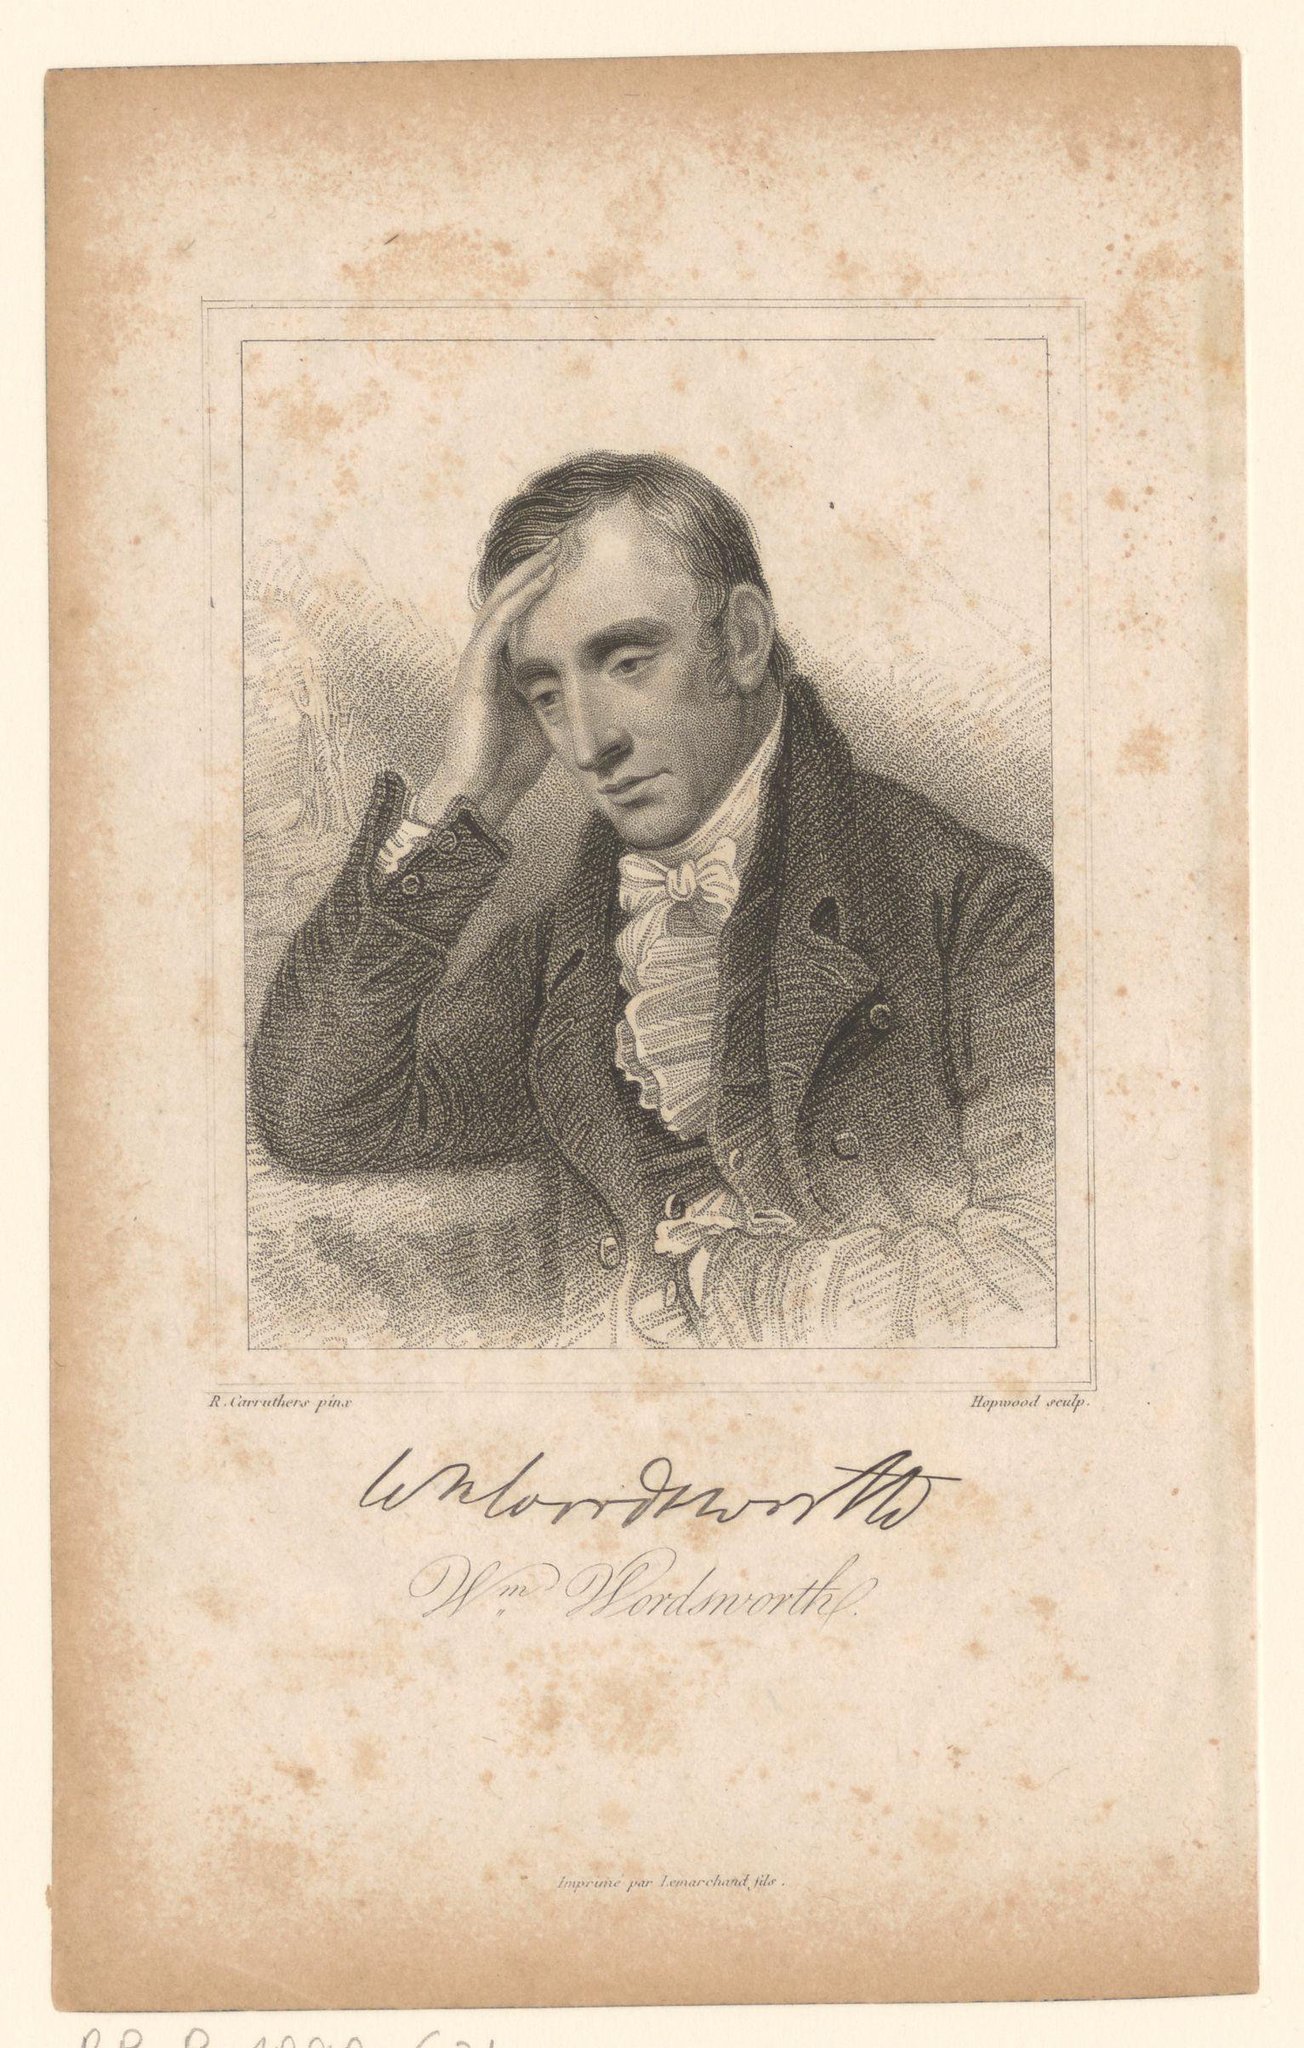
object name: print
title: Portret van William Wordsworth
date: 1828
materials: paper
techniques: etching, roulette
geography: paris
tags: william wordsworth, historical persons, portrait of a writer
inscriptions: collector's mark: Lugt 2228, collector's mark: Lugt 2760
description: Prent uit: Wordsworth, William. The Poetical Works of William Wordsworth. Parijs: Galignani, 1828.